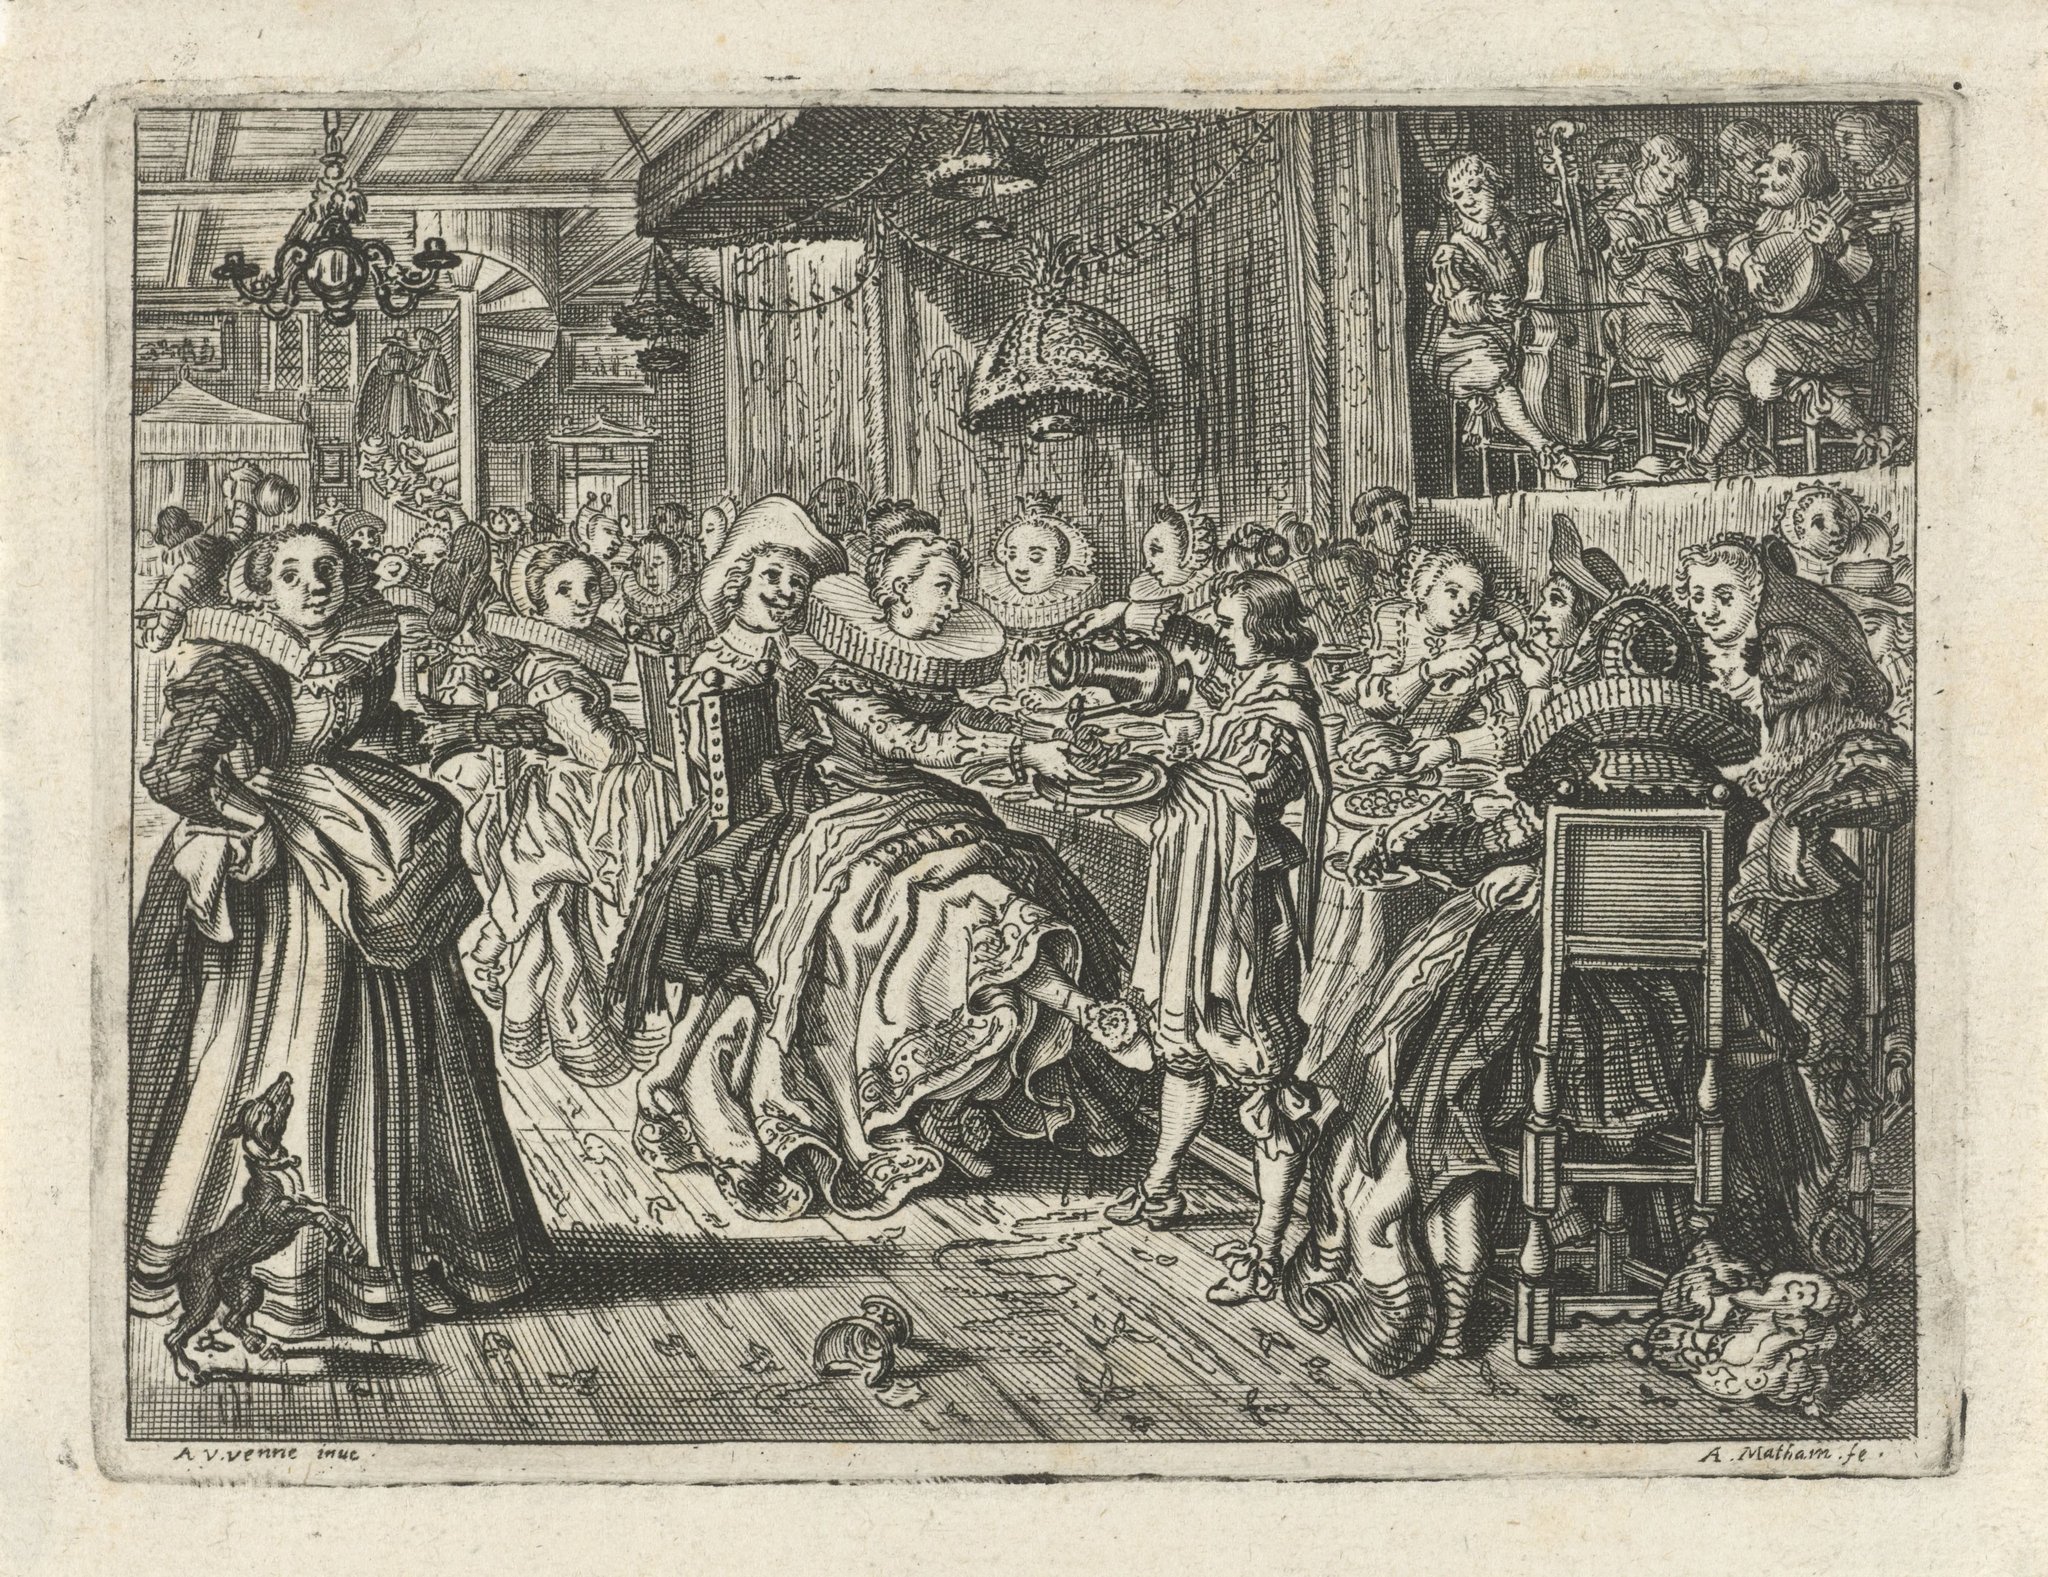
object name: print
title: Interieur met een huwelijksbanket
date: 1620-1660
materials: paper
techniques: engraving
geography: northern netherlands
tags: wedding feast, wedding meal, banquet of elegant company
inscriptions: collector's mark: Lugt 2228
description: Charmant geklede figuren aan een tafel waar wordt gegeten en gedronken. In het midden de bruid met een krans boven haar hoofd, bevestigt aan een baldakijn.